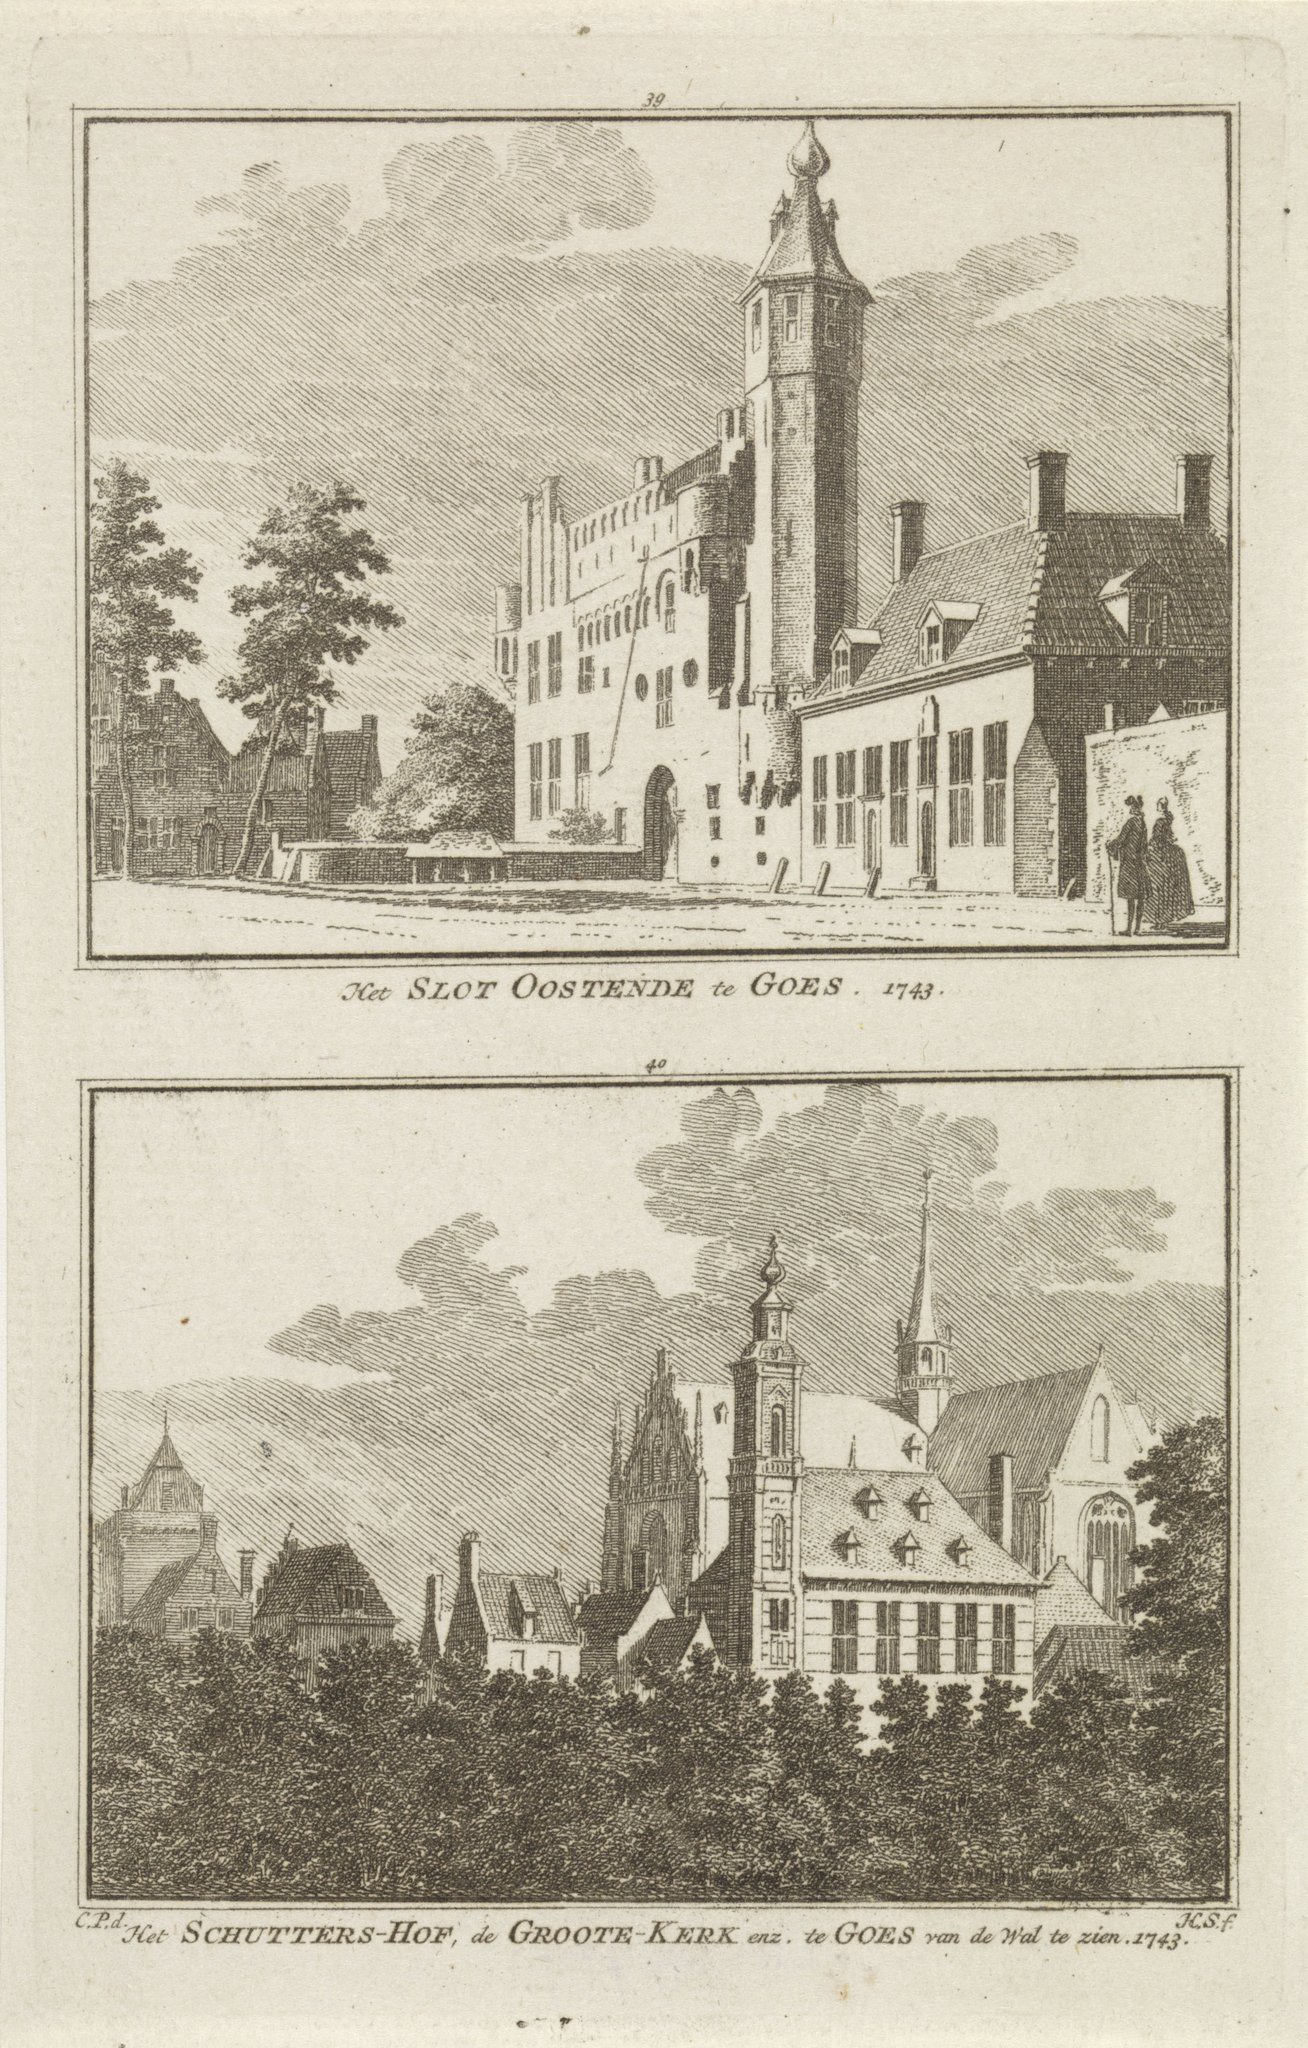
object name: book illustration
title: Gezichten op slot Ostende en de stad Goes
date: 1754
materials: paper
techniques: etching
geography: haarlem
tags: city-view in general; 'veduta', castle, slot ostende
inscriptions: collector's mark: Lugt 2228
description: Prent gebruikt in: Het verheerlykt Nederland of kabinet van hedendaagsche gezigten van steden, dorpen, sloten ... en andere voornaame stad- en landgebouwen, in en omtrent alle de byzondere Vereenigde Nederlandsche Provinciën : gedurende de laatste jaaren door vermaarden kunsttekenaren na het leven getekent en ... in 't koper gebragt ... dienende tot opheldering der beschryvinge van den Tegenwoordigen Staat der Vereenigde Nederlanden. Deel V, 1754. Amsterdam: Isaac Tirion, 1745-1774.